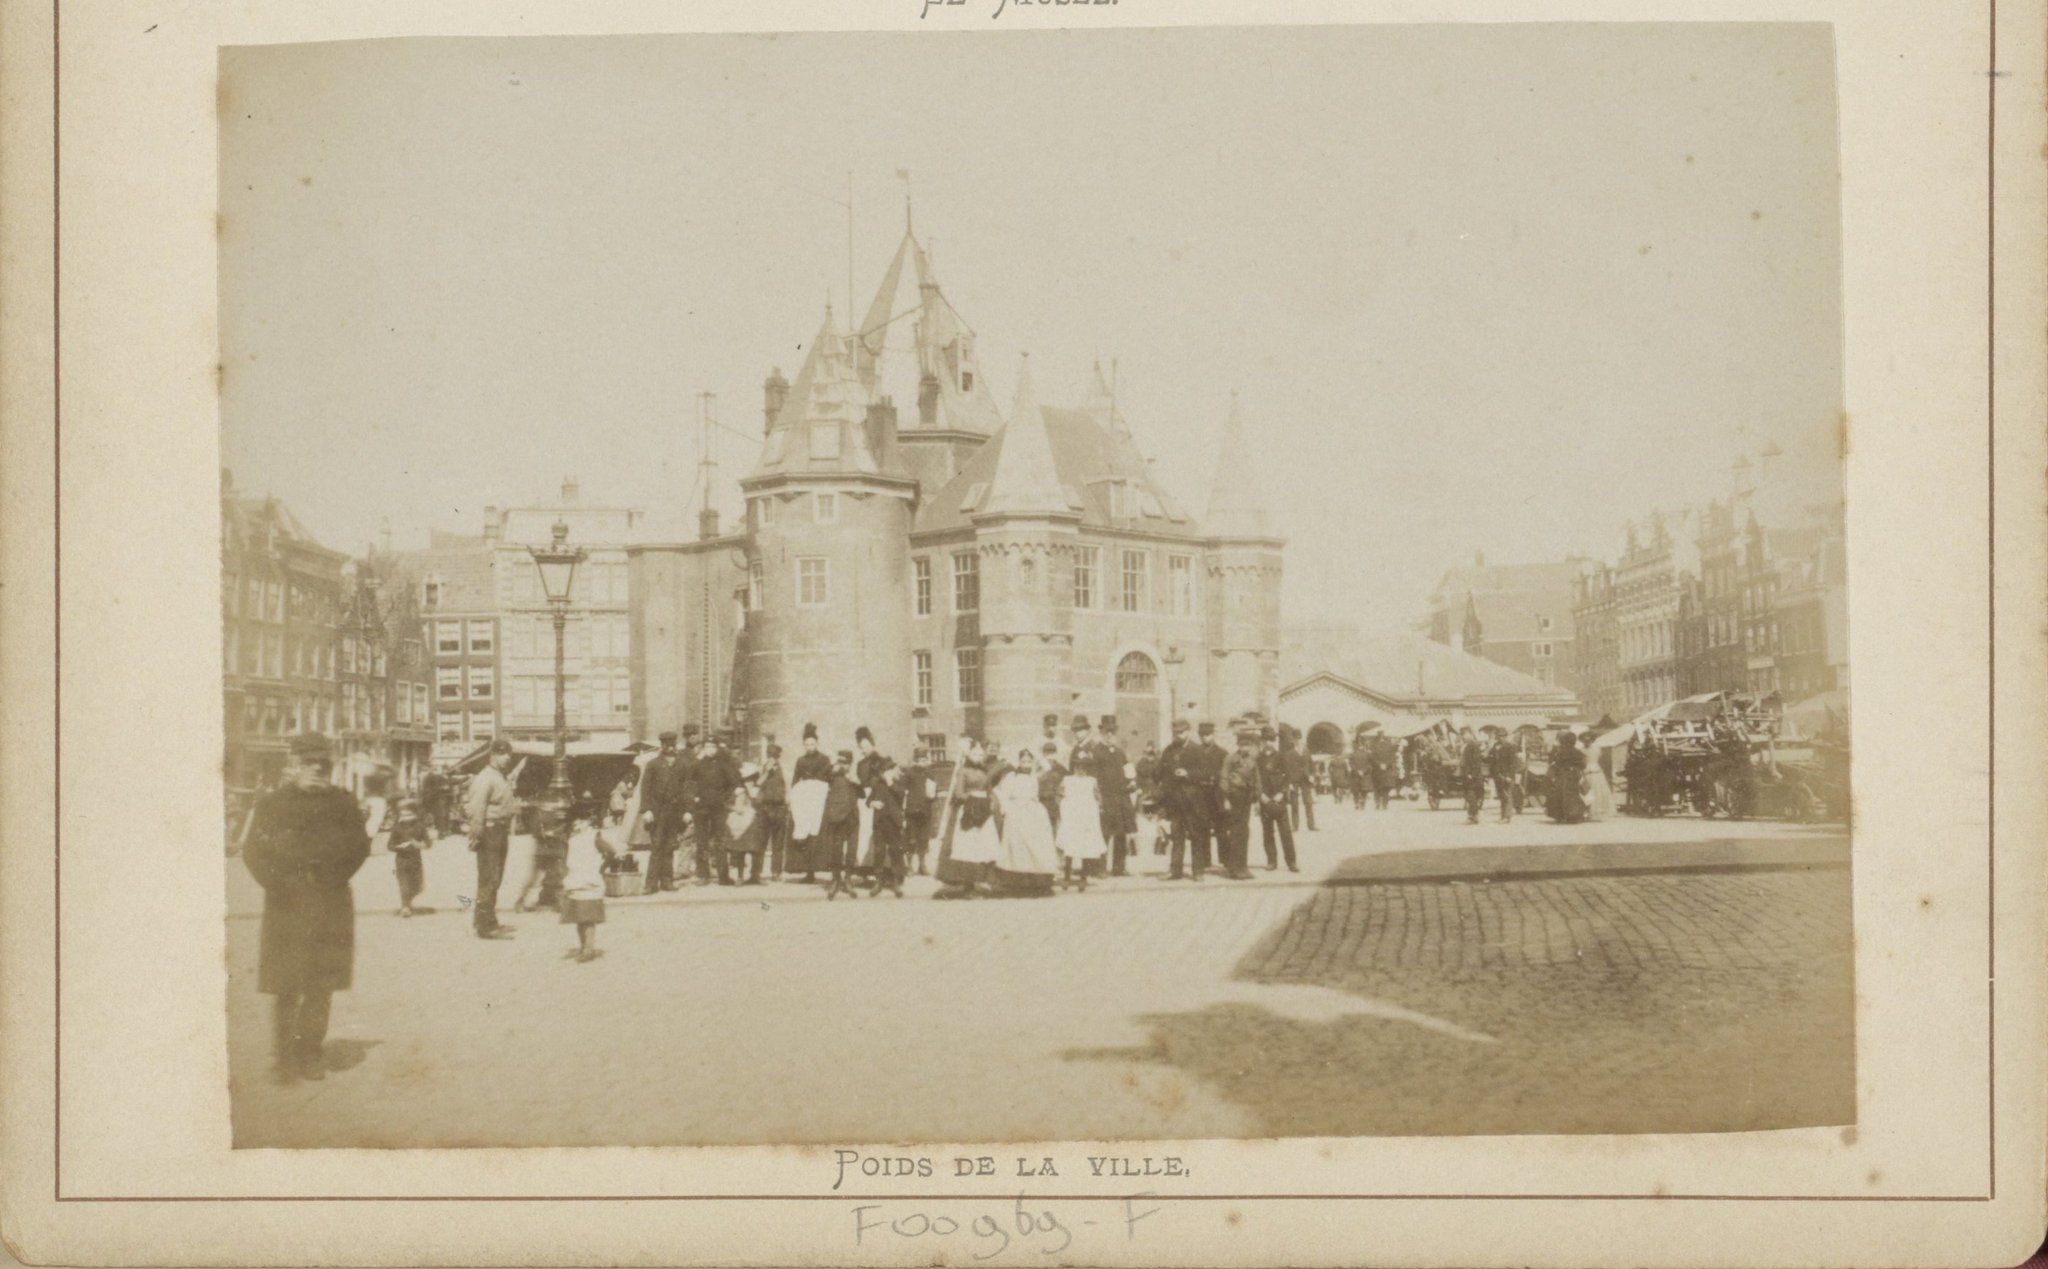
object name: photograph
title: Gezicht op de Nieuwmarkt in Amsterdam met het Waaggebouw en omstanders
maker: andries jager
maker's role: publisher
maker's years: 1825-1905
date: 1875-1910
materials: cardboard, paper, photographic support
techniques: albumen print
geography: amsterdam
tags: apron (+ women's clothes), weigh-house, square, place, circus, etc. (+ city(-scape) with figures, staffage)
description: Onderdeel van Leporelloalbum met 28 foto's van Amsterdam en omstreken.